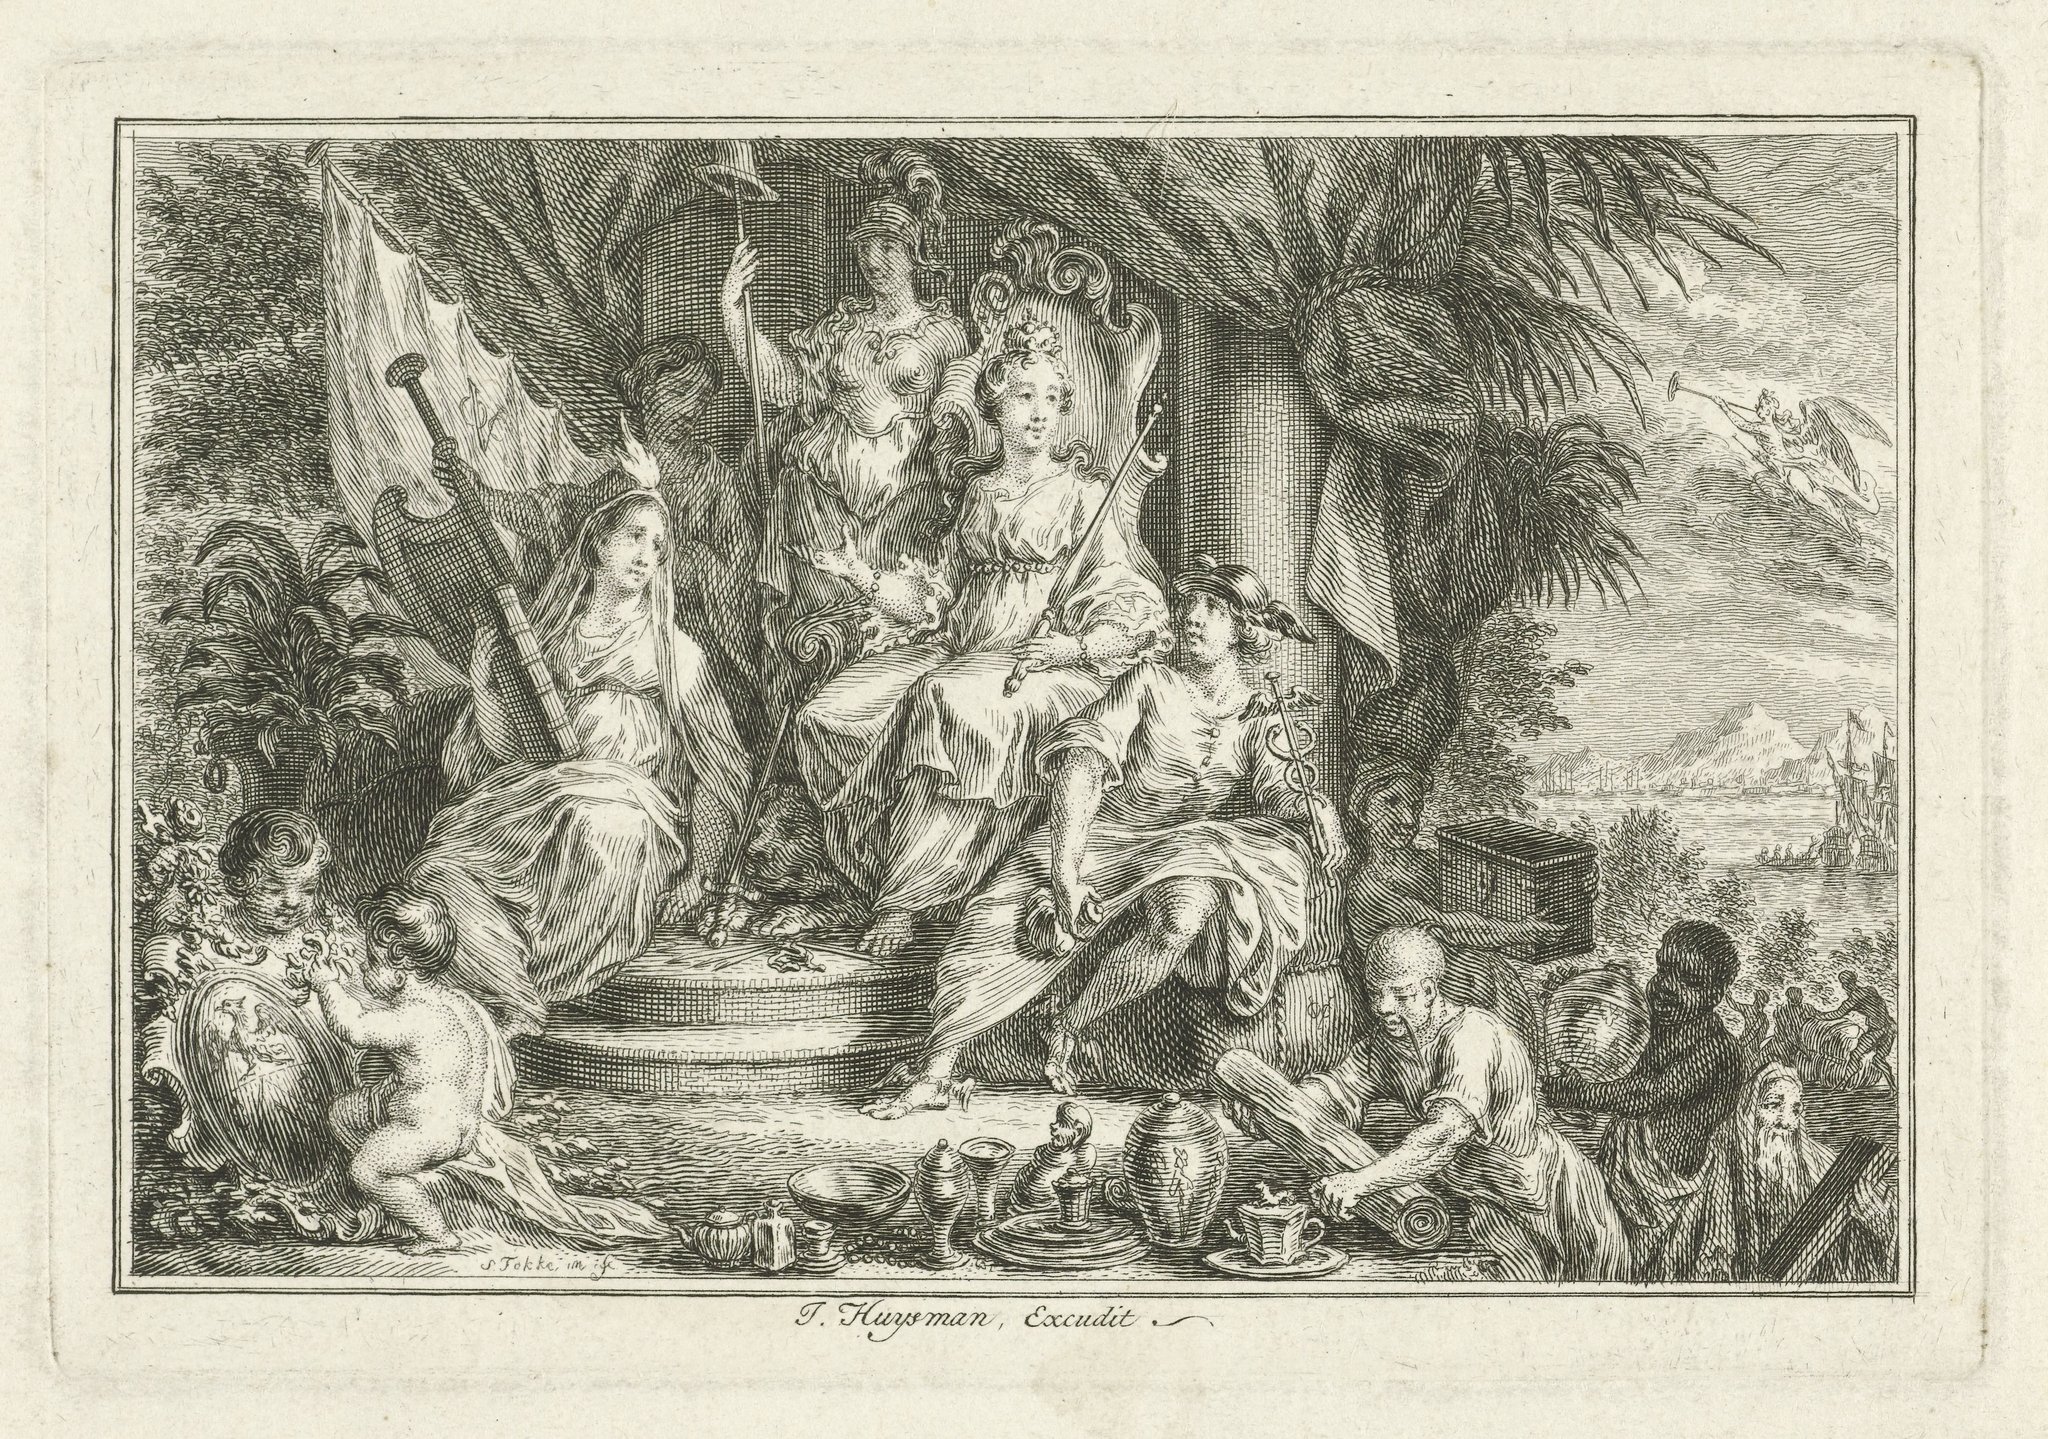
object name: print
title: Allegorie op de V.O.C.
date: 1752-1784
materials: paper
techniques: etching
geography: amsterdam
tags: trade-company, freedom, liberty; 'libertà' (ripa), attributes of mercury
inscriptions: collector's mark: Lugt 2228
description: In het midden troont Batavia, de personificatie van de V.O.C., met scepter. Aan haar voeten ligt de Hollandse Leeuw, wakend over een bundel pijlen en een zwaard. Achter Batavia staat de Vrijheid met vrijheidshoed op stok en wordt een vlag vastgehouden met het monogram van de V.O.C. Mercurius, de god van de handel, zit rechts van Batavia. Oosterse koopmannen leggen cadeau's neer terwijl geheel rechts twee putti bij een wapenschild met de beeltenis van een adelaar spelen.